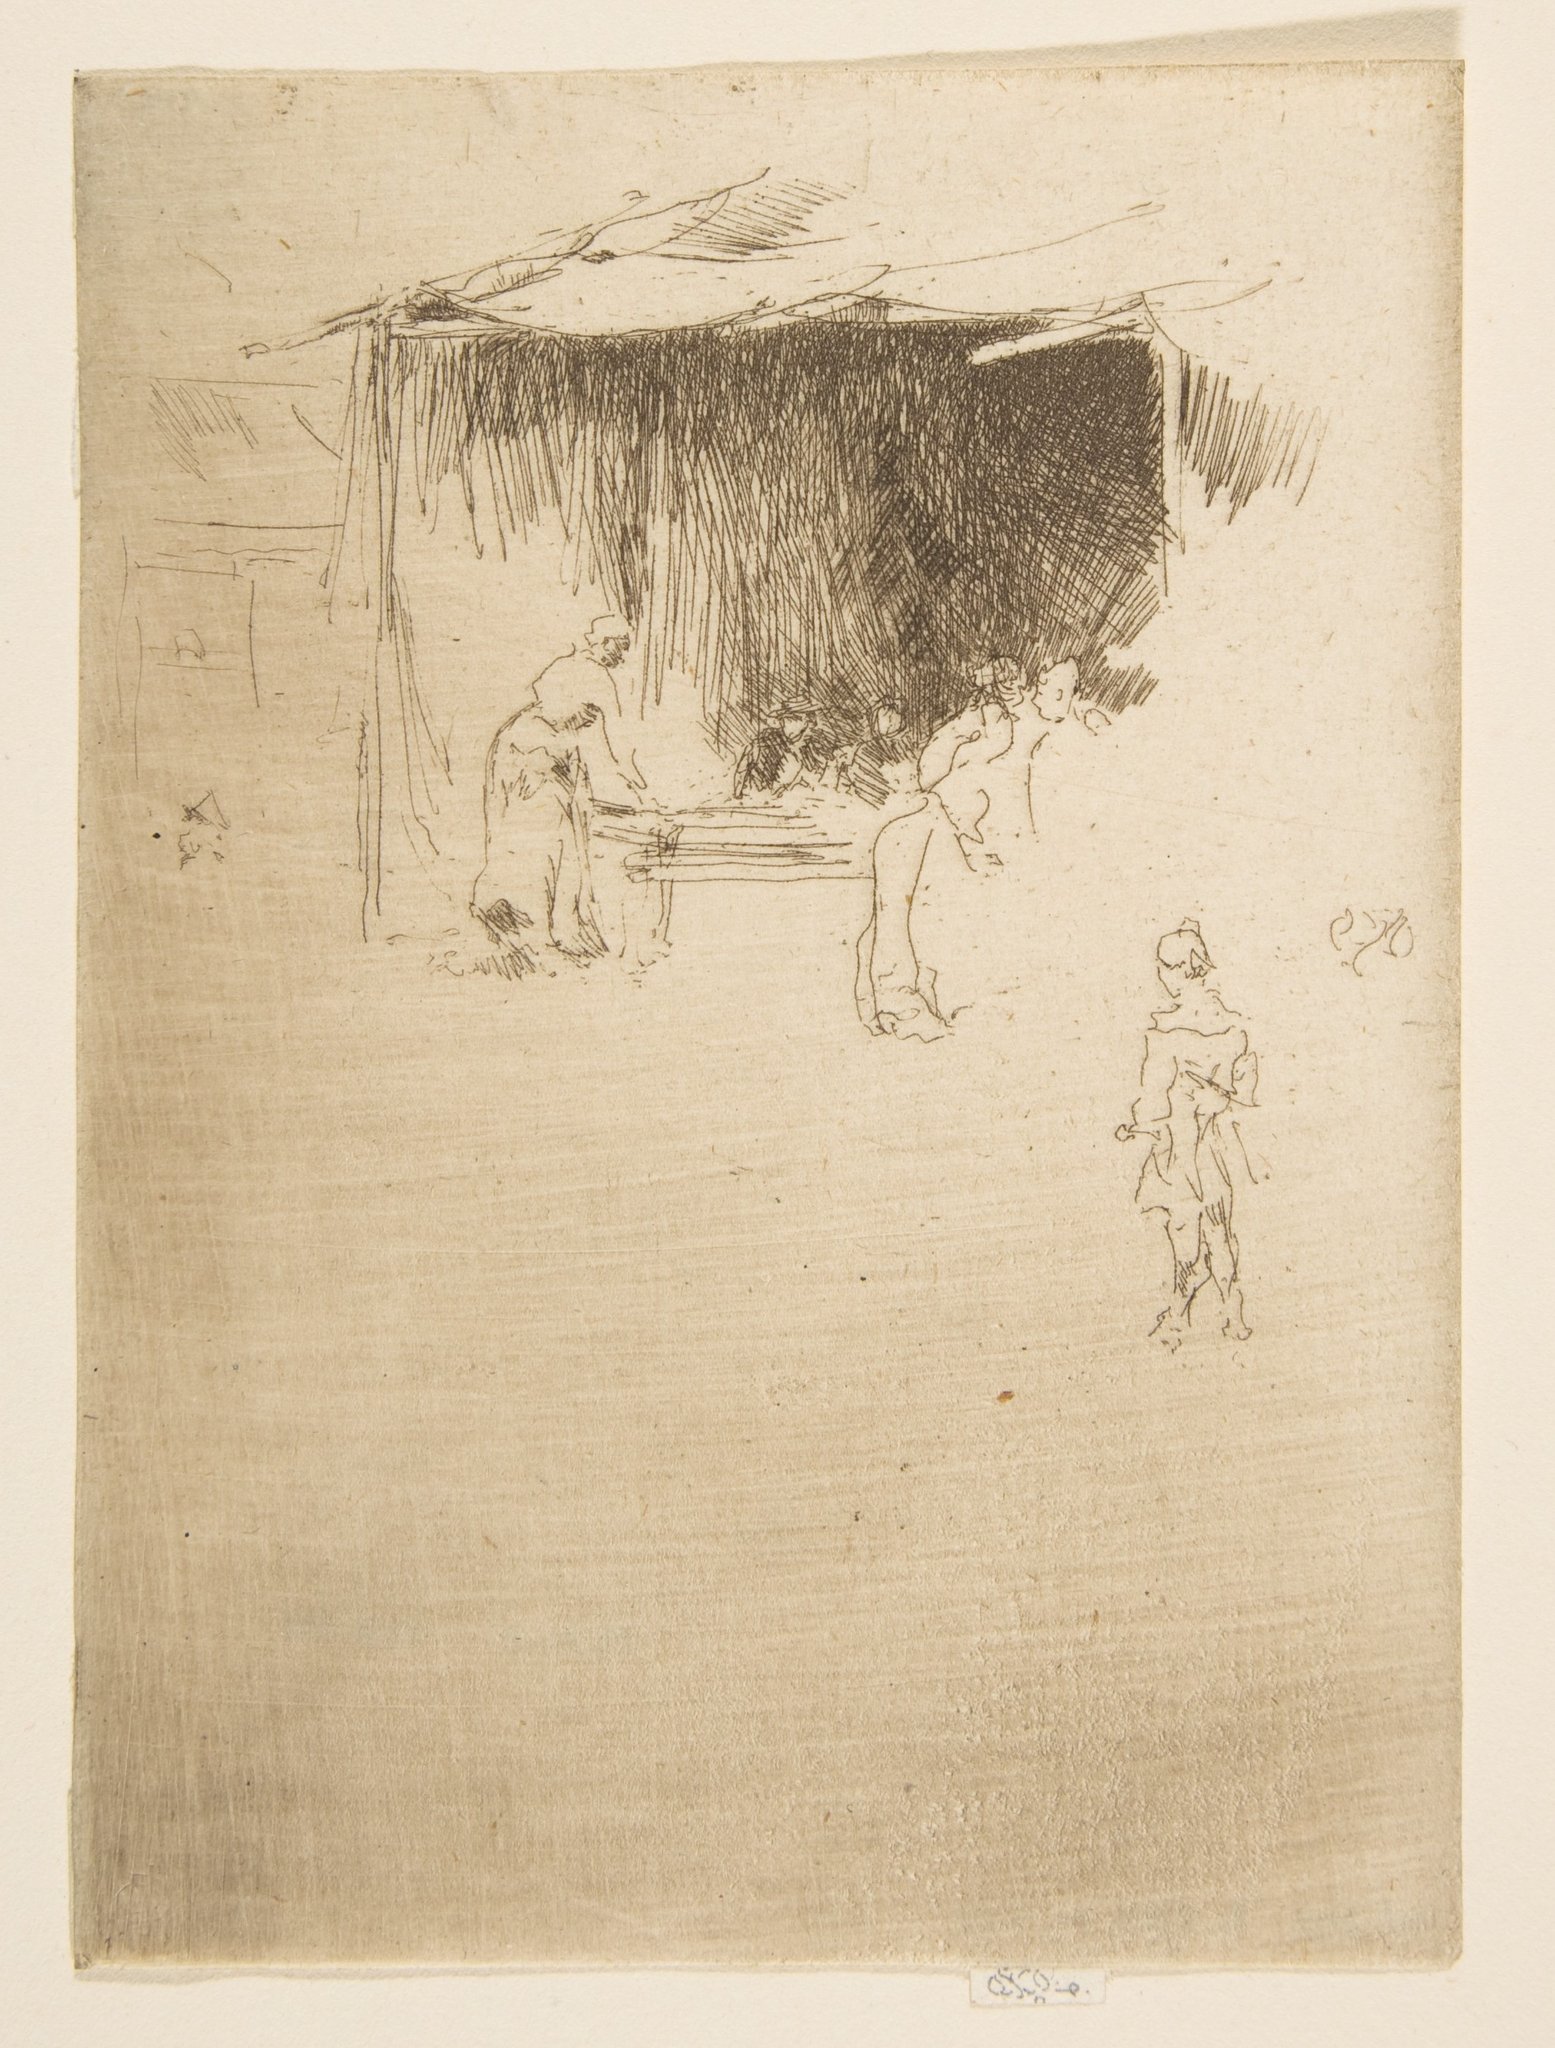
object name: print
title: Booth at a Fair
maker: james mcneill whistler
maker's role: artist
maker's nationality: american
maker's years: 1834-1903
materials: ink, paper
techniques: drypoint, etching, printing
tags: human figures